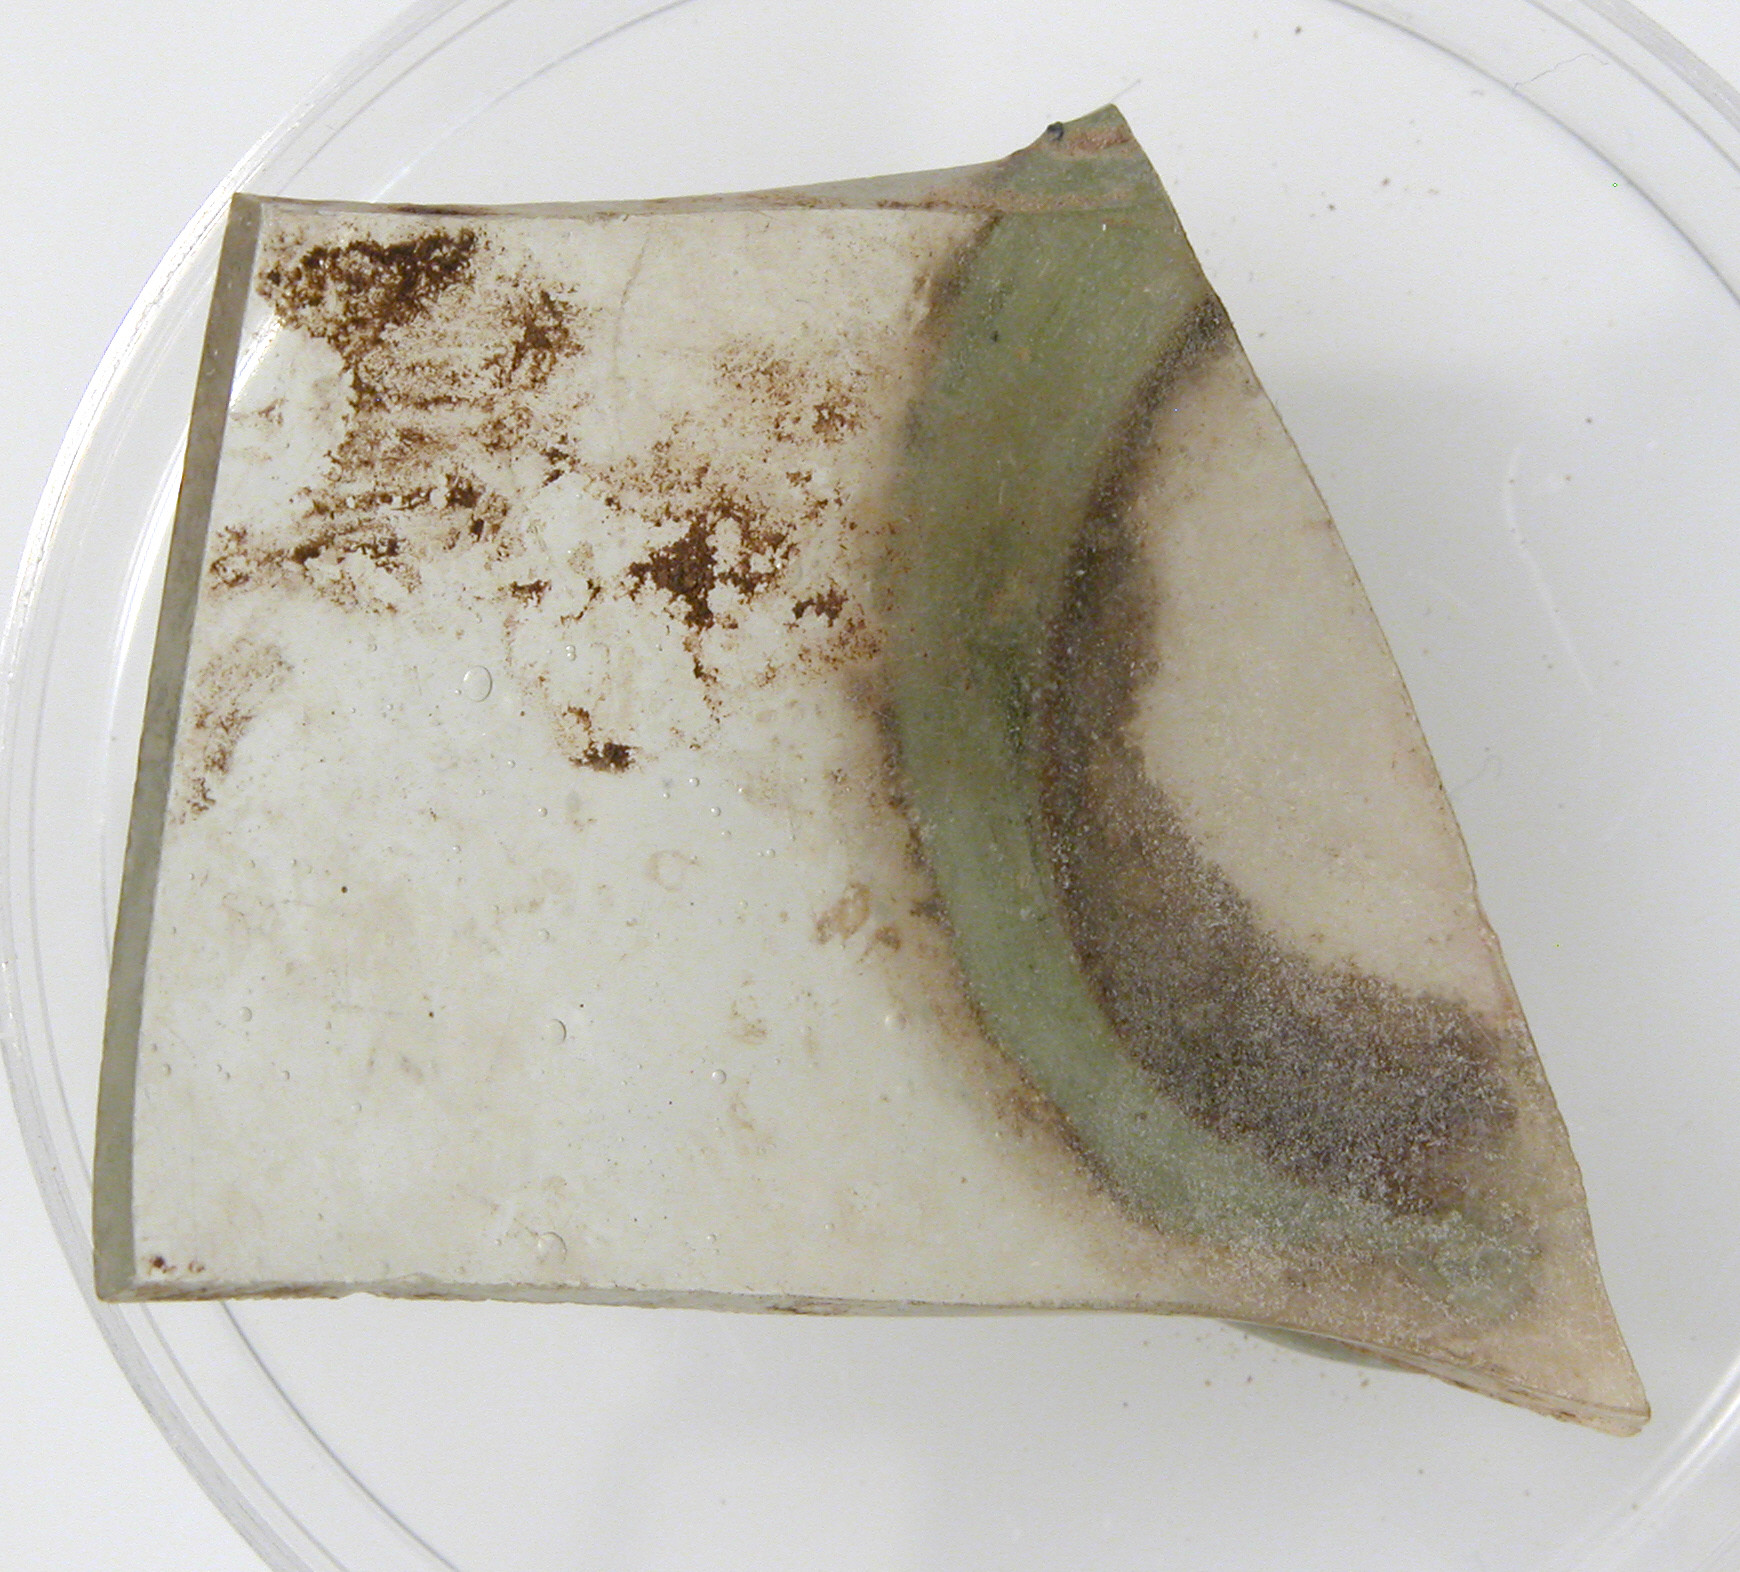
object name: fragment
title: Bottom of a Vessel with Foot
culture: coptic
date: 301-433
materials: glass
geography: egypt